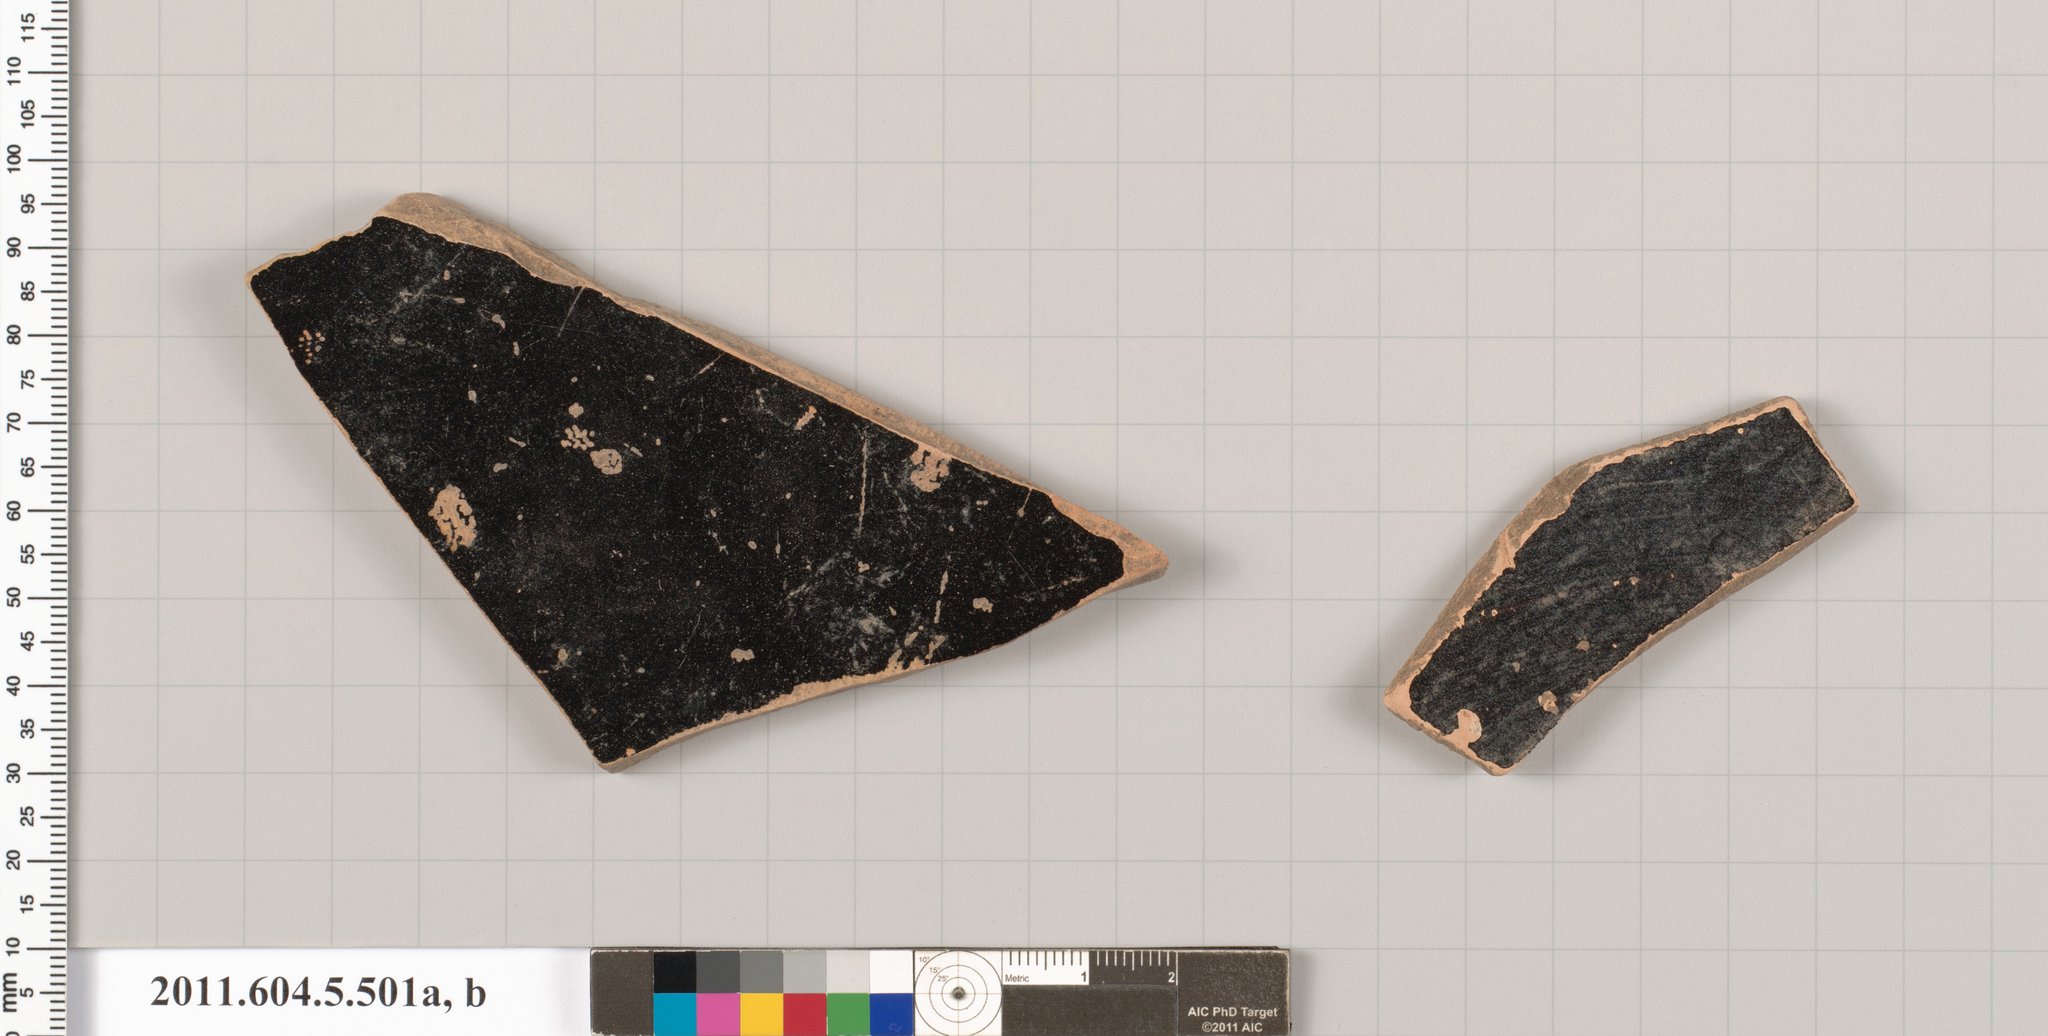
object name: kylix fragment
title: Terracotta fragments of a kylix (drinking cup)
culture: greek, attic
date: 600-401 BCE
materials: terracotta